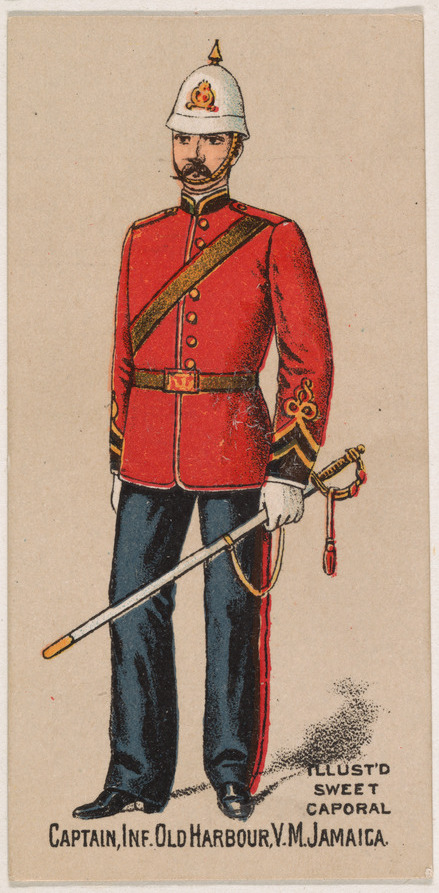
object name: print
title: Captain, Infantry, Old Harbour, V.M., Jamaica, from the Military Series (N224) issued by Kinney Tobacco Company to promote Sweet Caporal Cigarettes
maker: kinney brothers tobacco company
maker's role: publisher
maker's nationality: american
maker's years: 1869-2011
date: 1888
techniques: color lithograph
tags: military,men